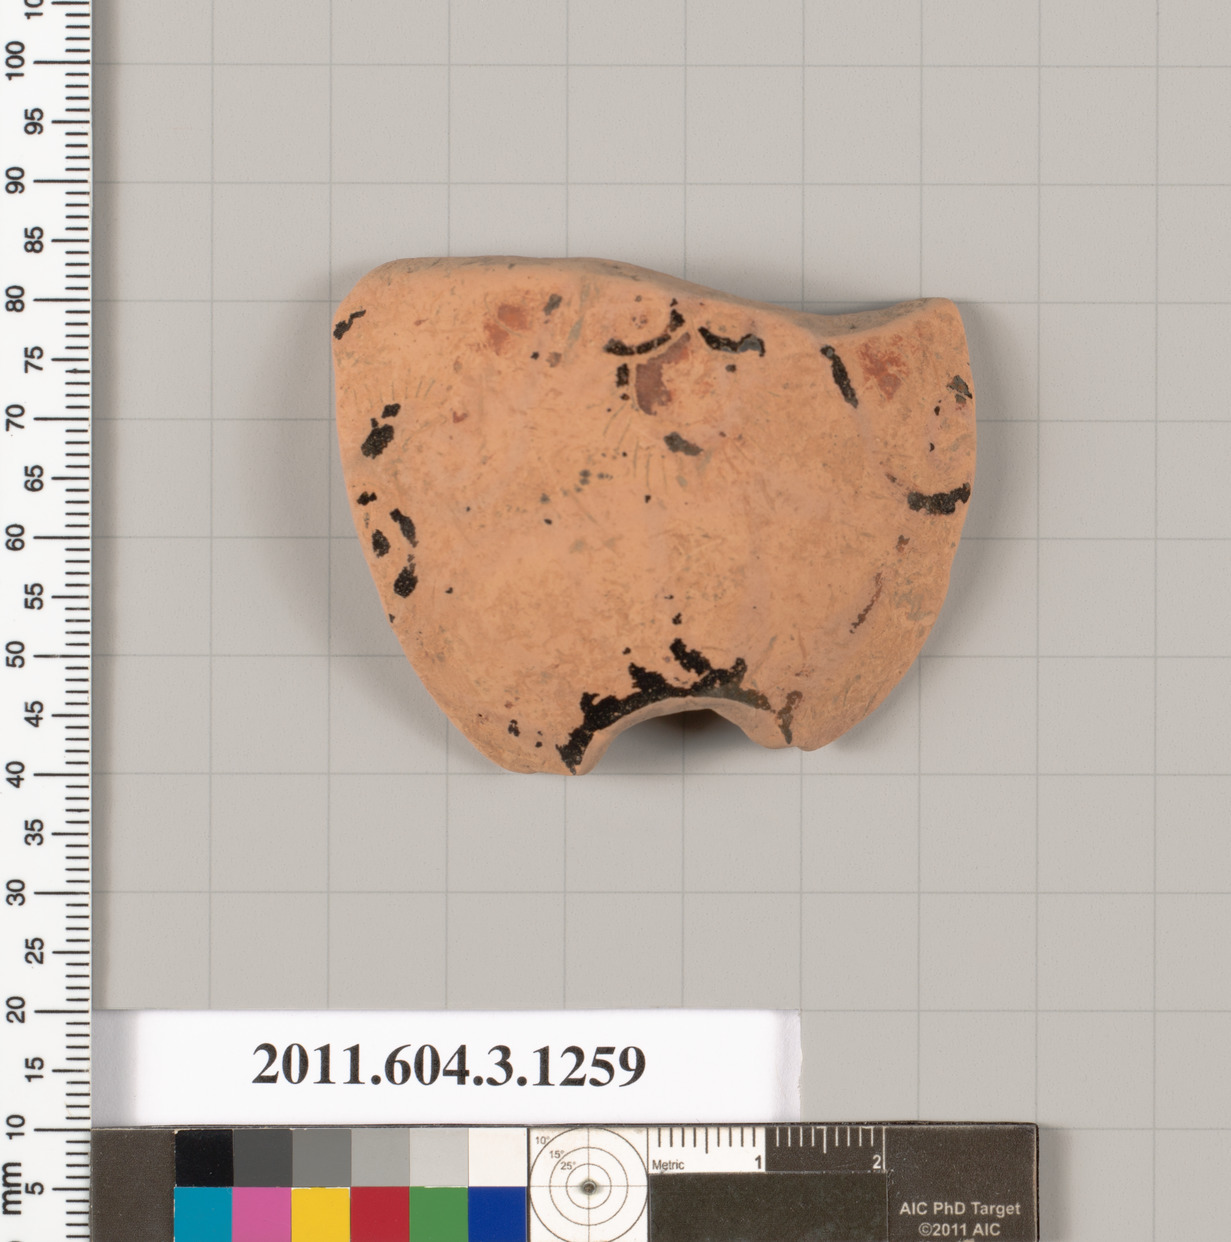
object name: undetermined shape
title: Terracotta fragment of an undetermined shape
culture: greek, attic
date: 600-401 BCE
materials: terracotta